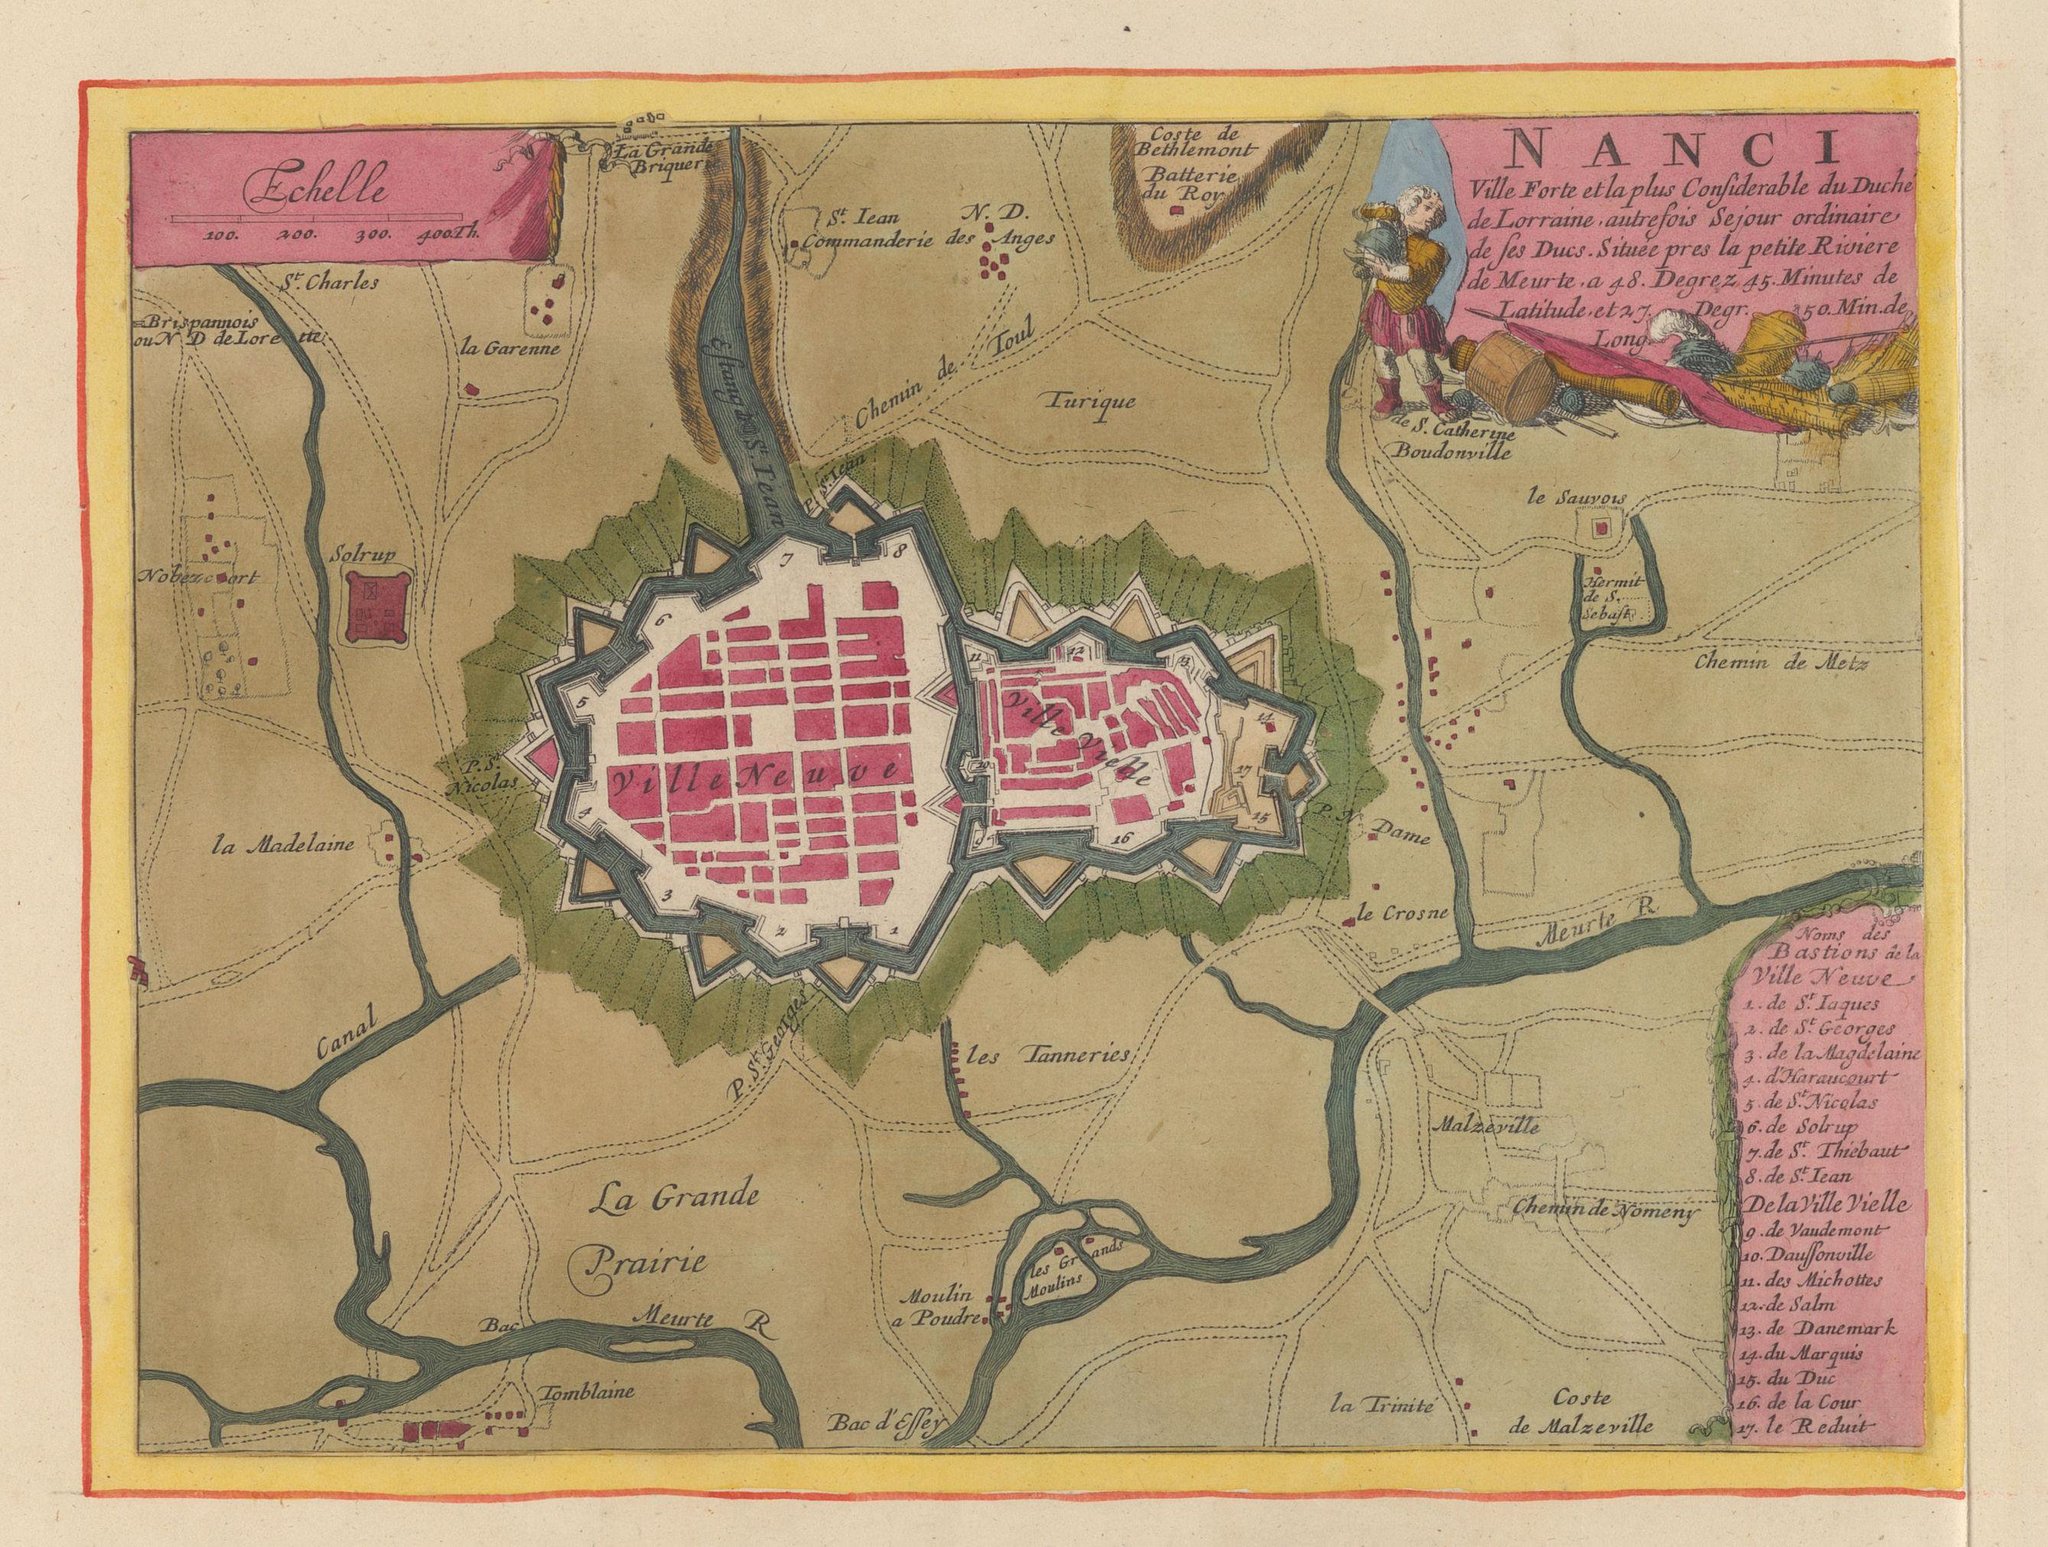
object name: print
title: Plan de la citadelle de Nancy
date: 1700-1702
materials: paper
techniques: engraving, hand coloring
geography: the hague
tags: maps of cities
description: Deze plattegrond is in meerdere atlassen gebruikt. Onder andere in: Les forces de l'Europe. 10 dln. Amsterdam: Pieter Mortier, ca. 1700. En in: Les forces de l'Europe. 12 dln. Amsterdam: Pieter Mortier, 1702. Door het ontbreken van de marges van deze prent is onduidelijk om welke staat het gaat. Derhalve is niet te bepalen uit welke van deze publicaties dit exemplaar komt. Later is deze zelfde prent door Pieter van der Aa gebruikt in twee publicaties. Gezien het eind van de werkzame periode van de inkleurder van de prenten in dit album is het niet mogelijk dat deze prent uit een van die publicaties komt.